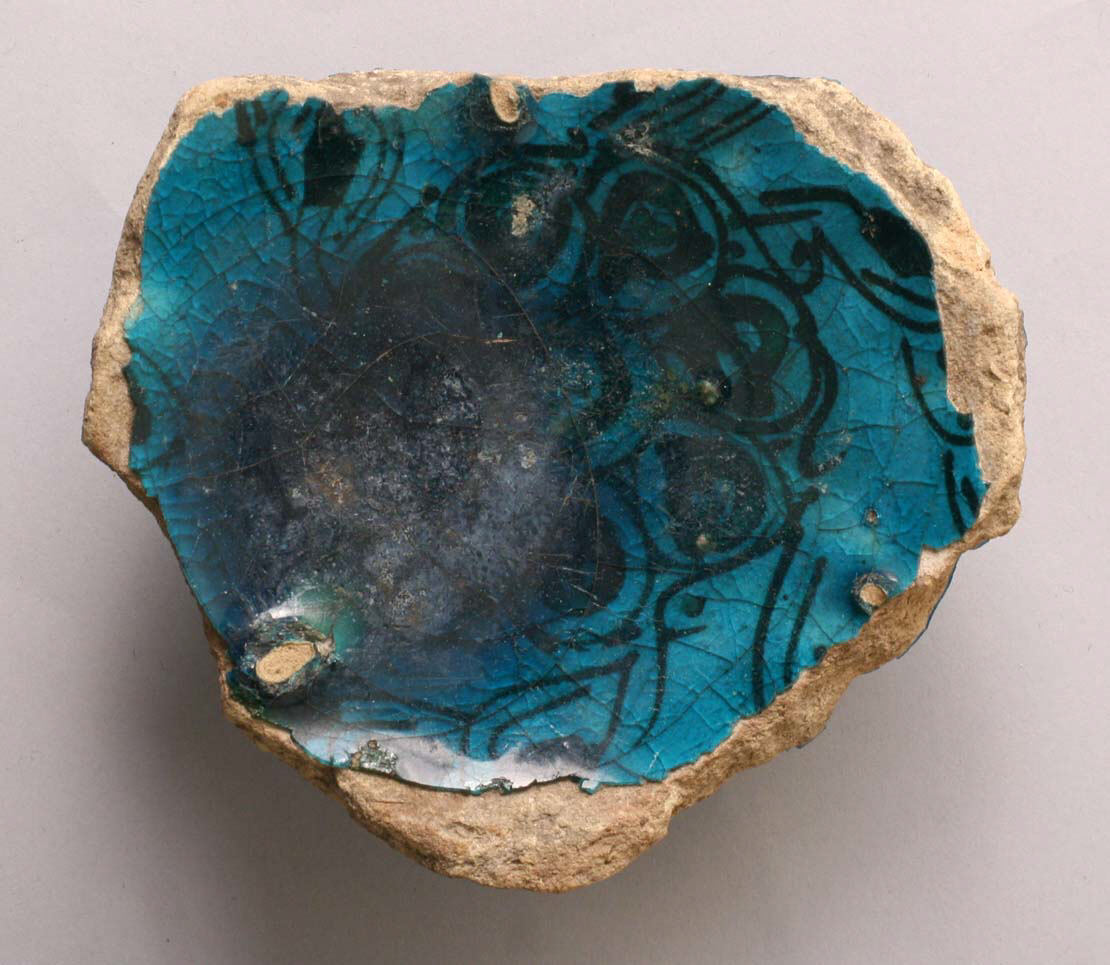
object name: ceramic fragment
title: Fragment of Bowl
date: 1301-1400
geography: syria